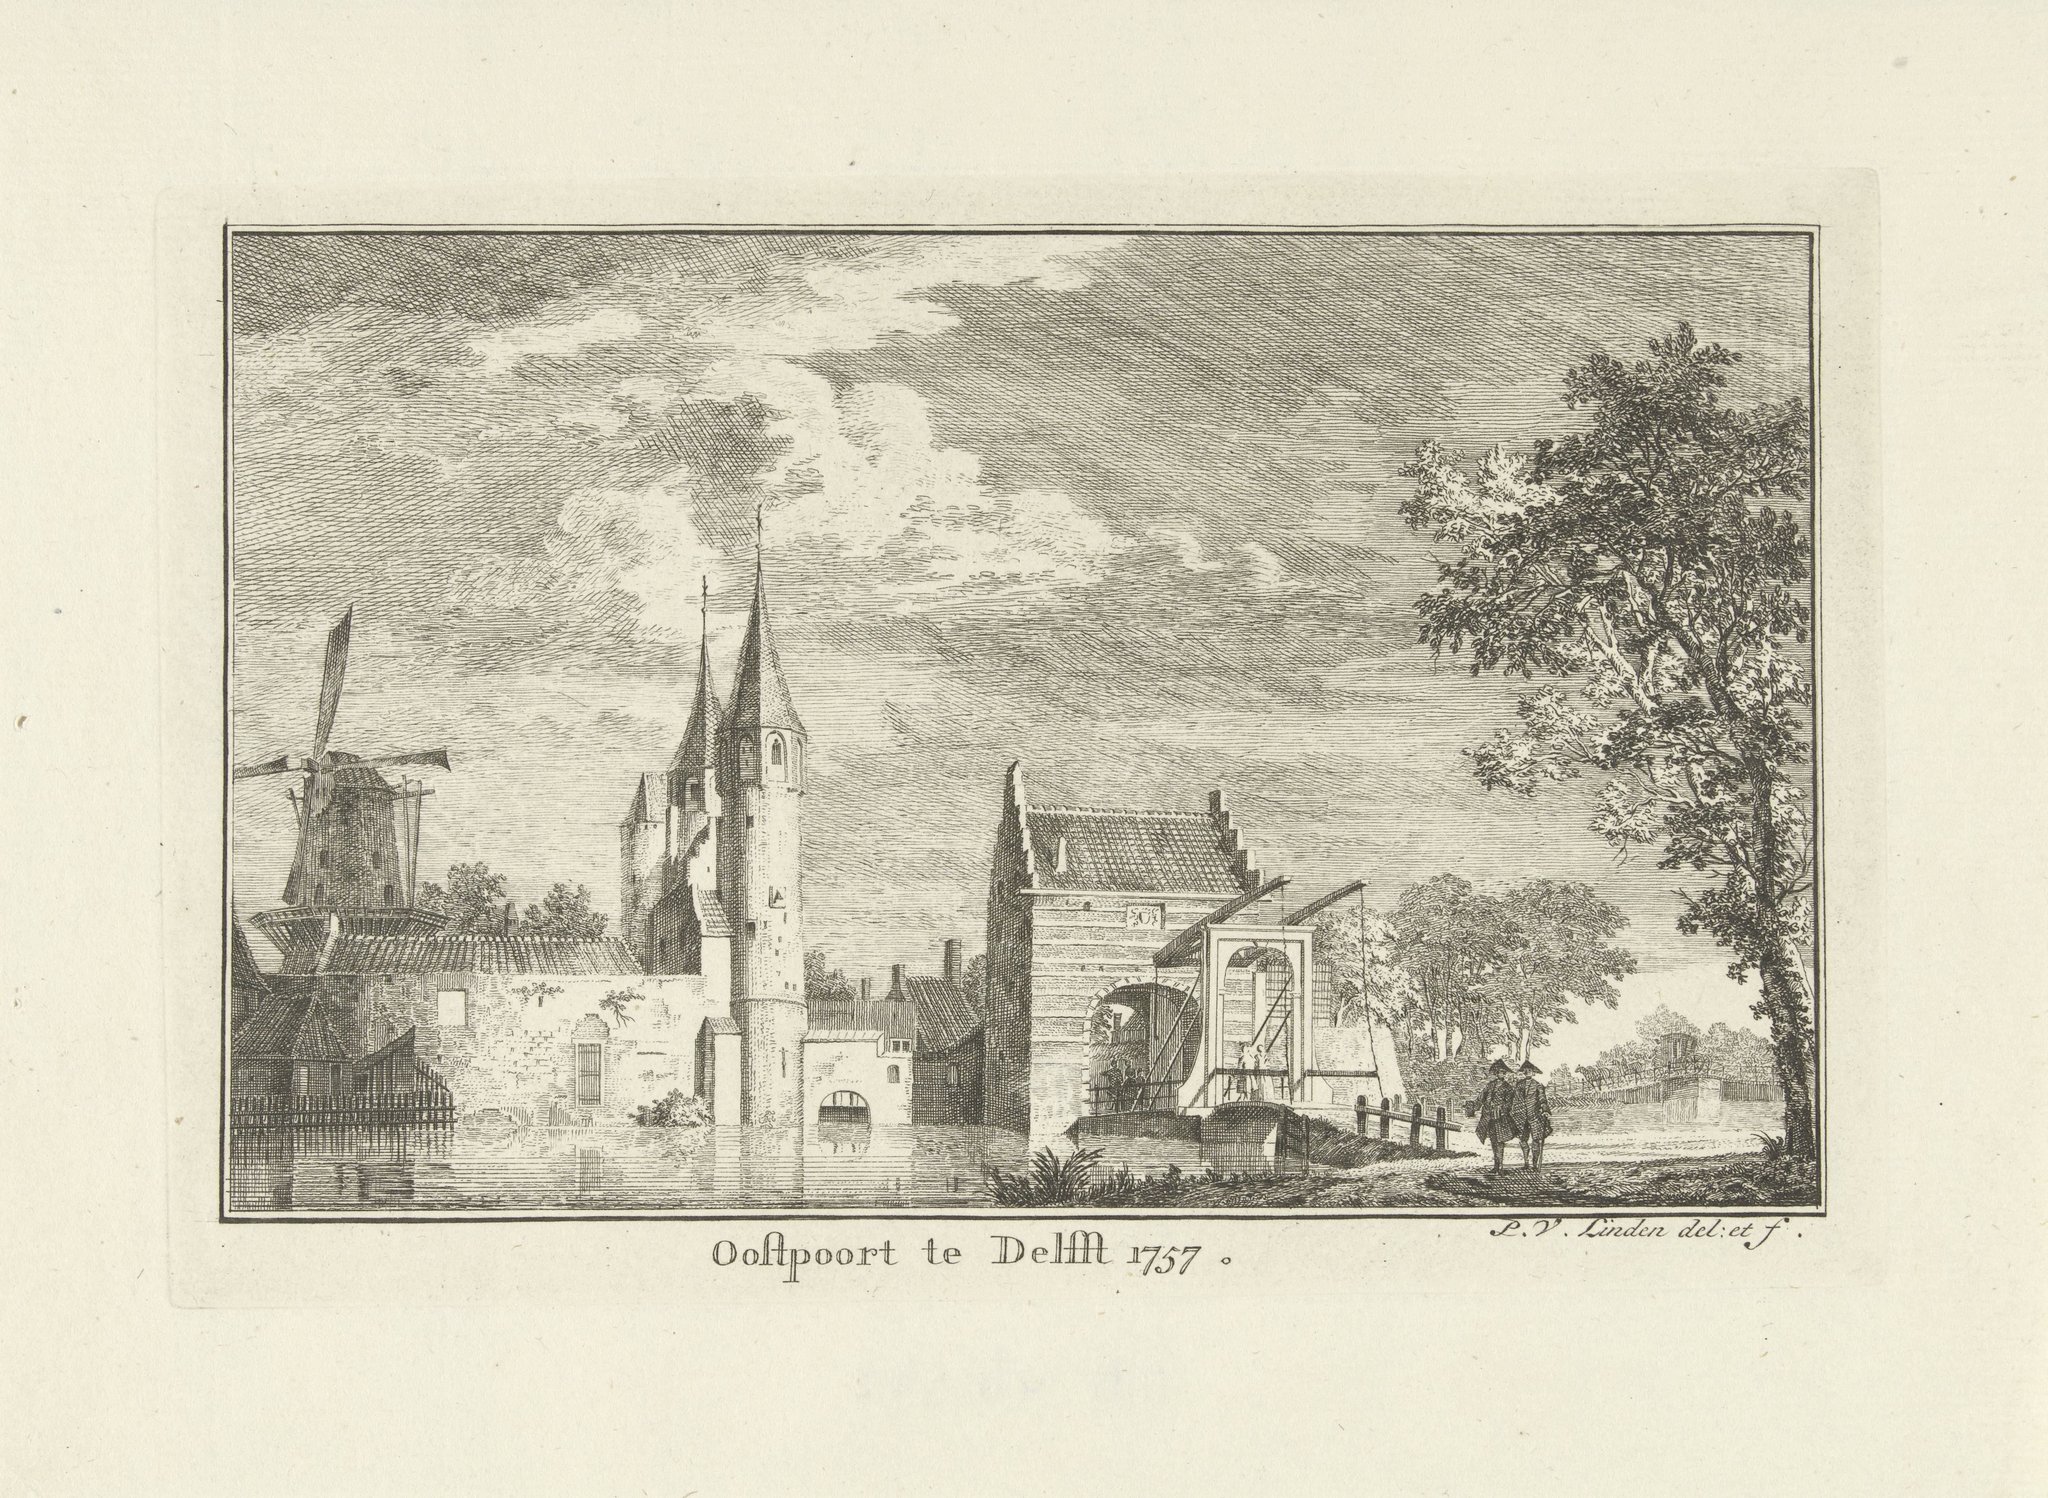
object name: print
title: Oostpoort te Delft, 1757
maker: paulus van liender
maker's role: draughtsman, print maker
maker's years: 1731-1797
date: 1757-1797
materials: paper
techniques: etching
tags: city-gate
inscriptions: collector's mark: Lugt 2228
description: Gezicht op de Oostpoort in Delft, bestaande uit een land- en waterpoort. Rechts op de voorgrond lopen twee figuren op een weg.